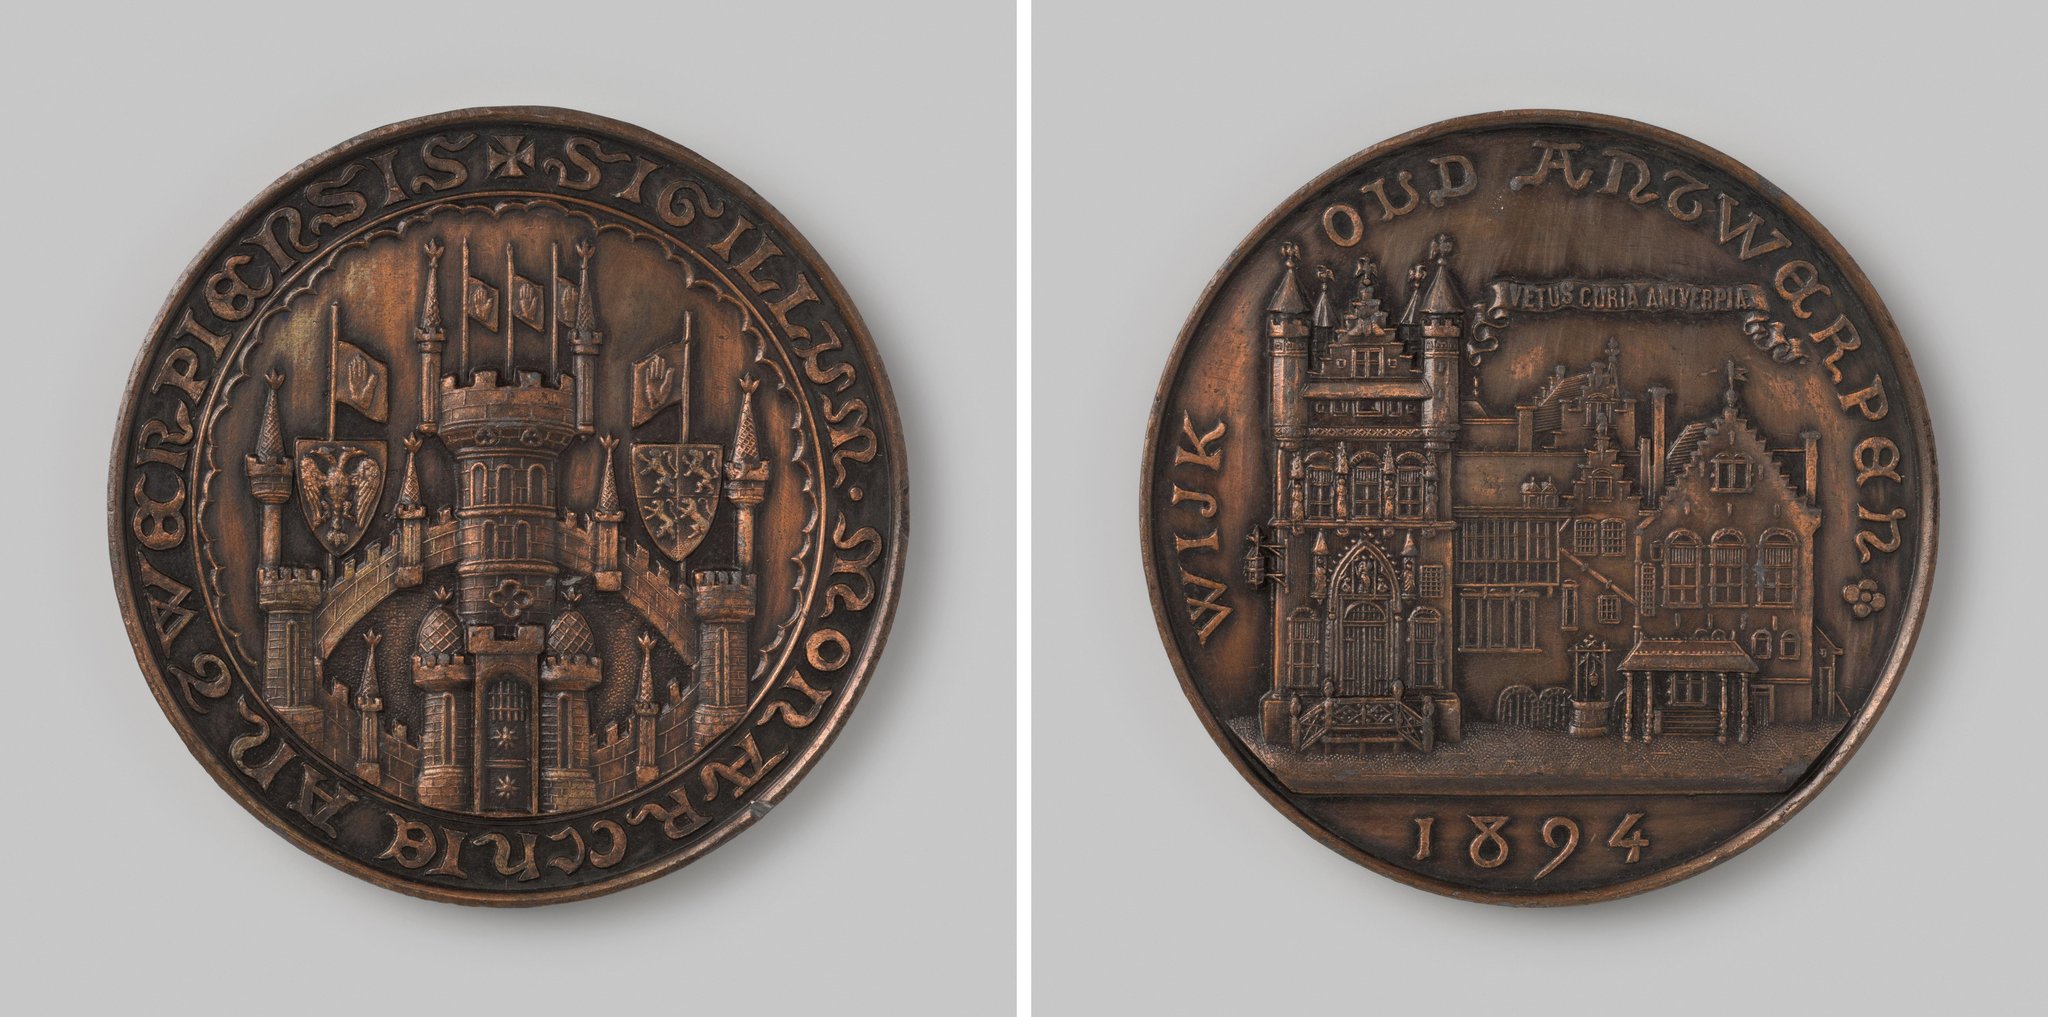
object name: history medal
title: Wereldtentoonstelling te Antwerpen - Wijk Oud Antwerpen 1894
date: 1894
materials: bronze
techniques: striking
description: Bronzen penning, op de voorzijde een burcht, met twee banieren waaraan wapenschilden, deels binnen een veelpas, met omschrift in gotische letters, op de keerzijde enkele gebouwen met tekstbanderol, omschrift in gotische letters en afsnedetekst.